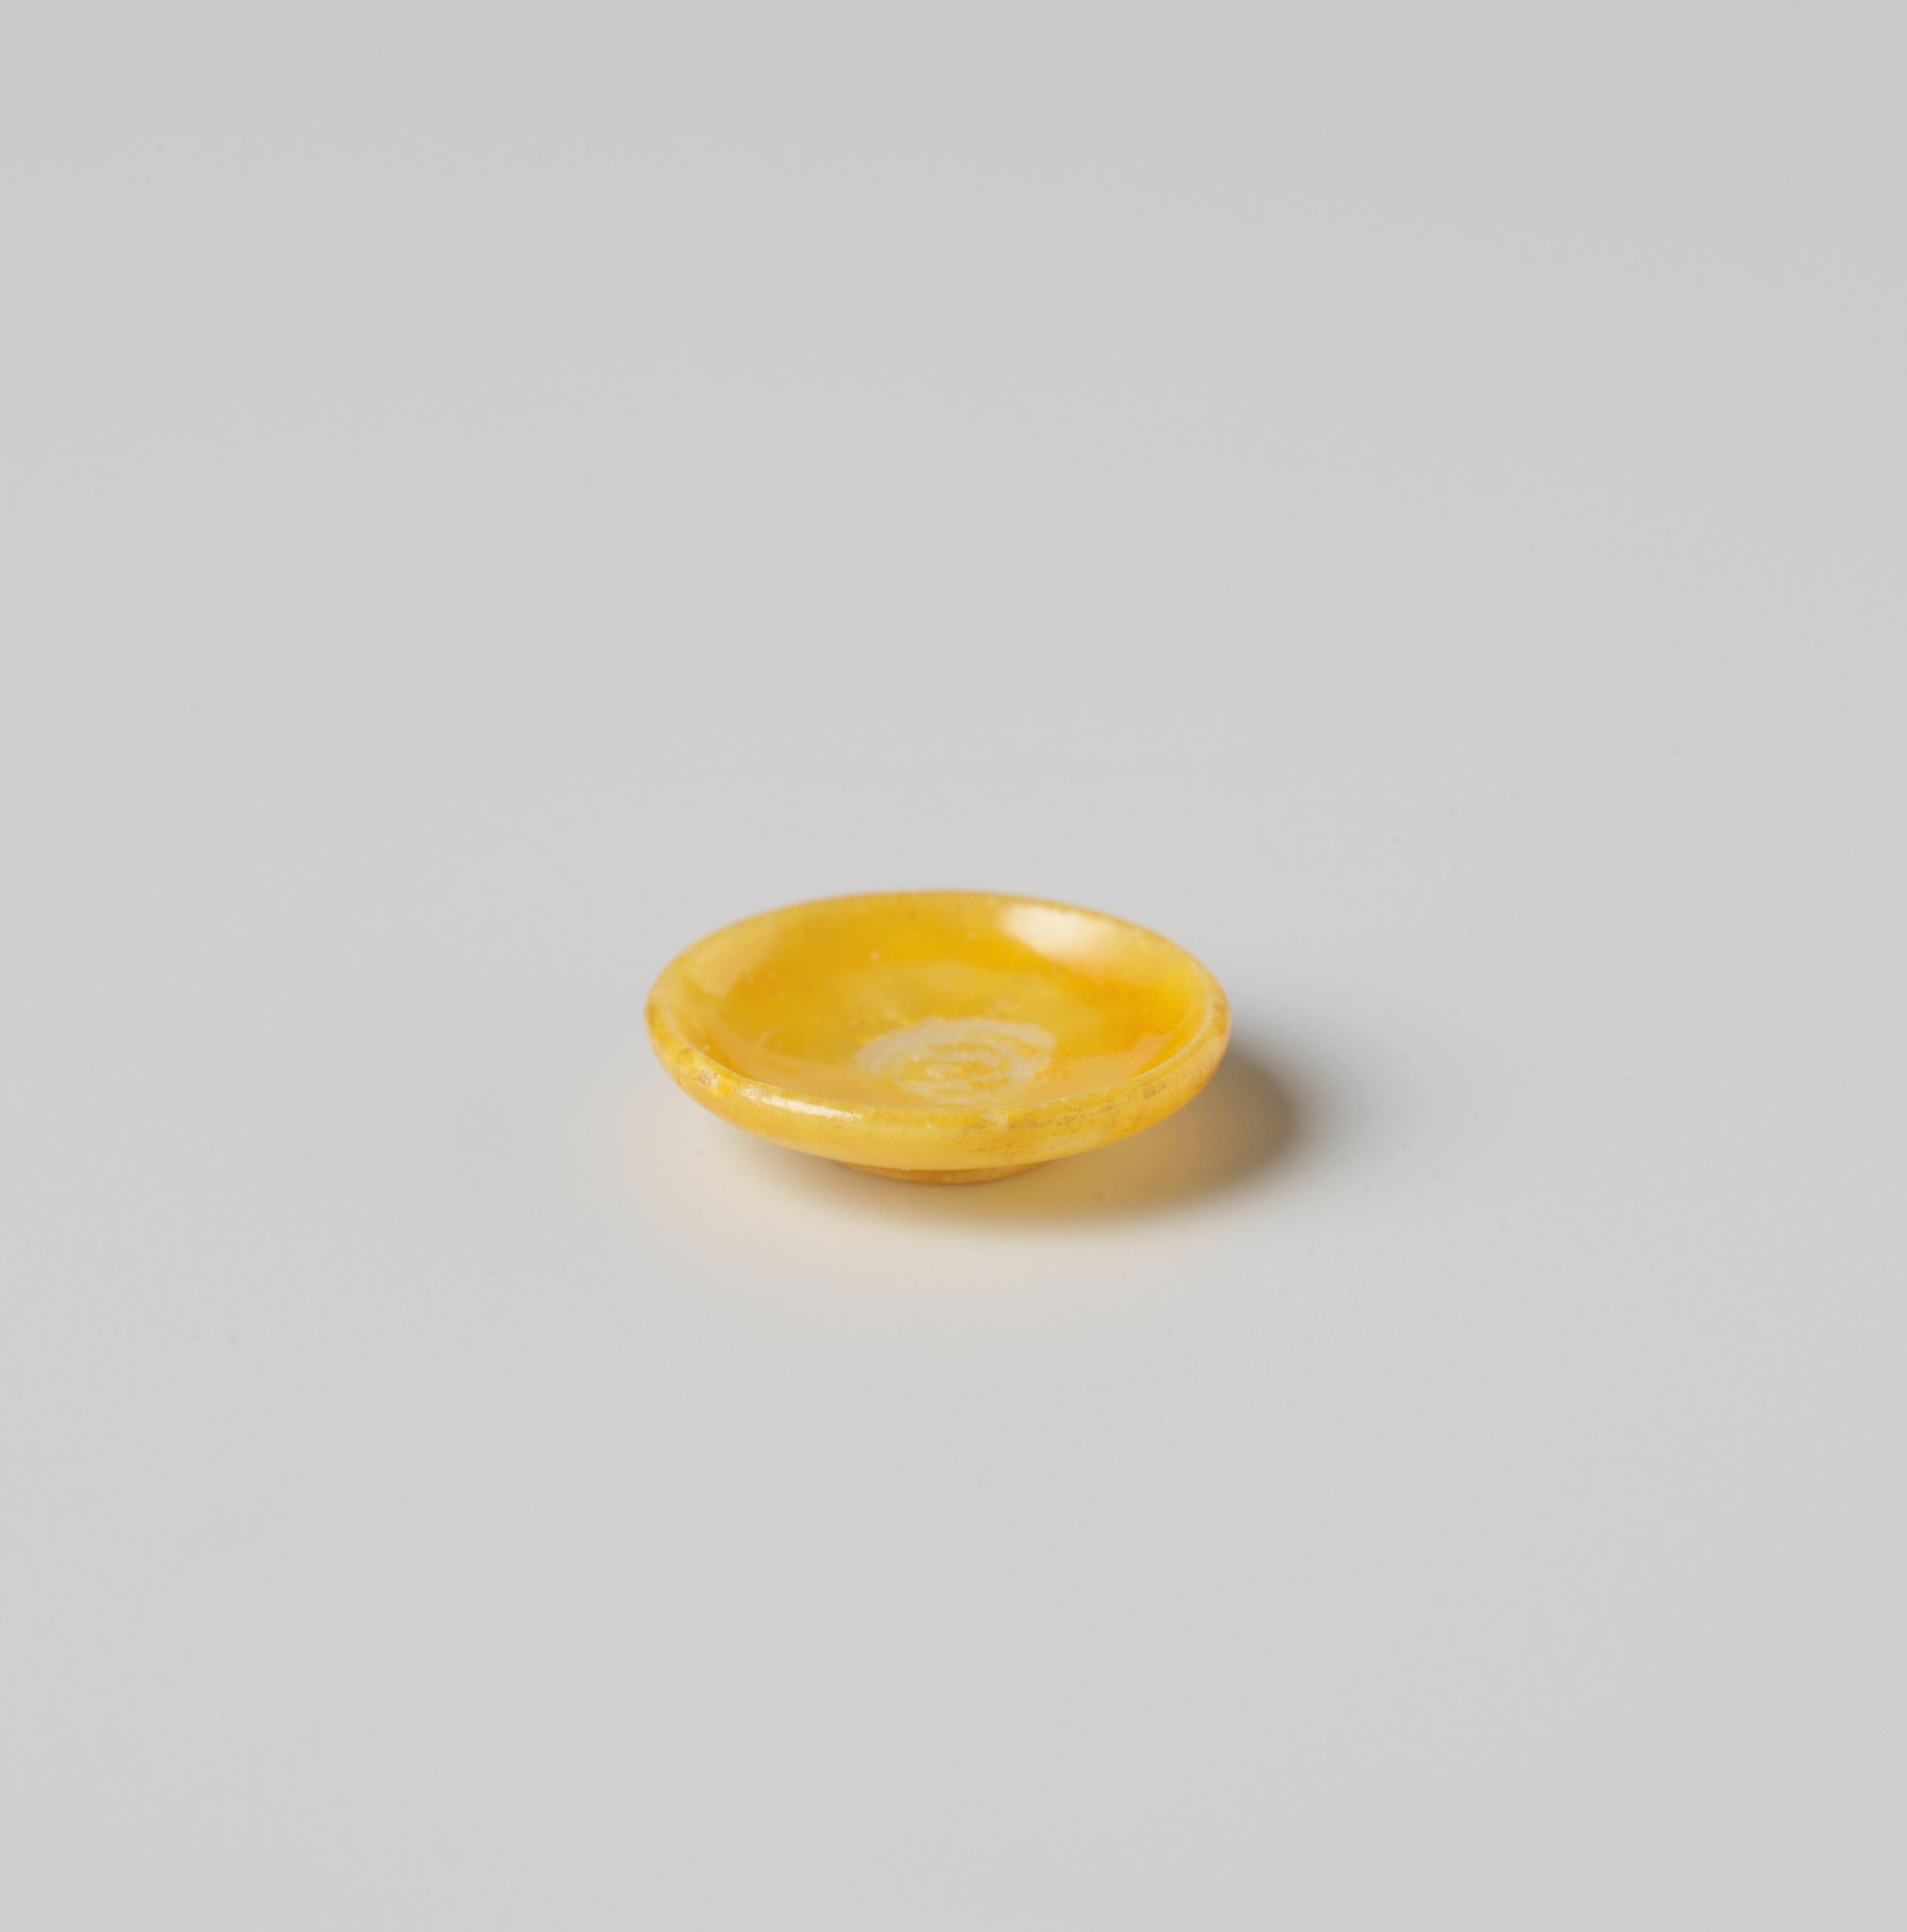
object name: miniature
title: Schotel, geelgelakt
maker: Anonymous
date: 1750-1800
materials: alabaster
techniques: lacquer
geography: germany